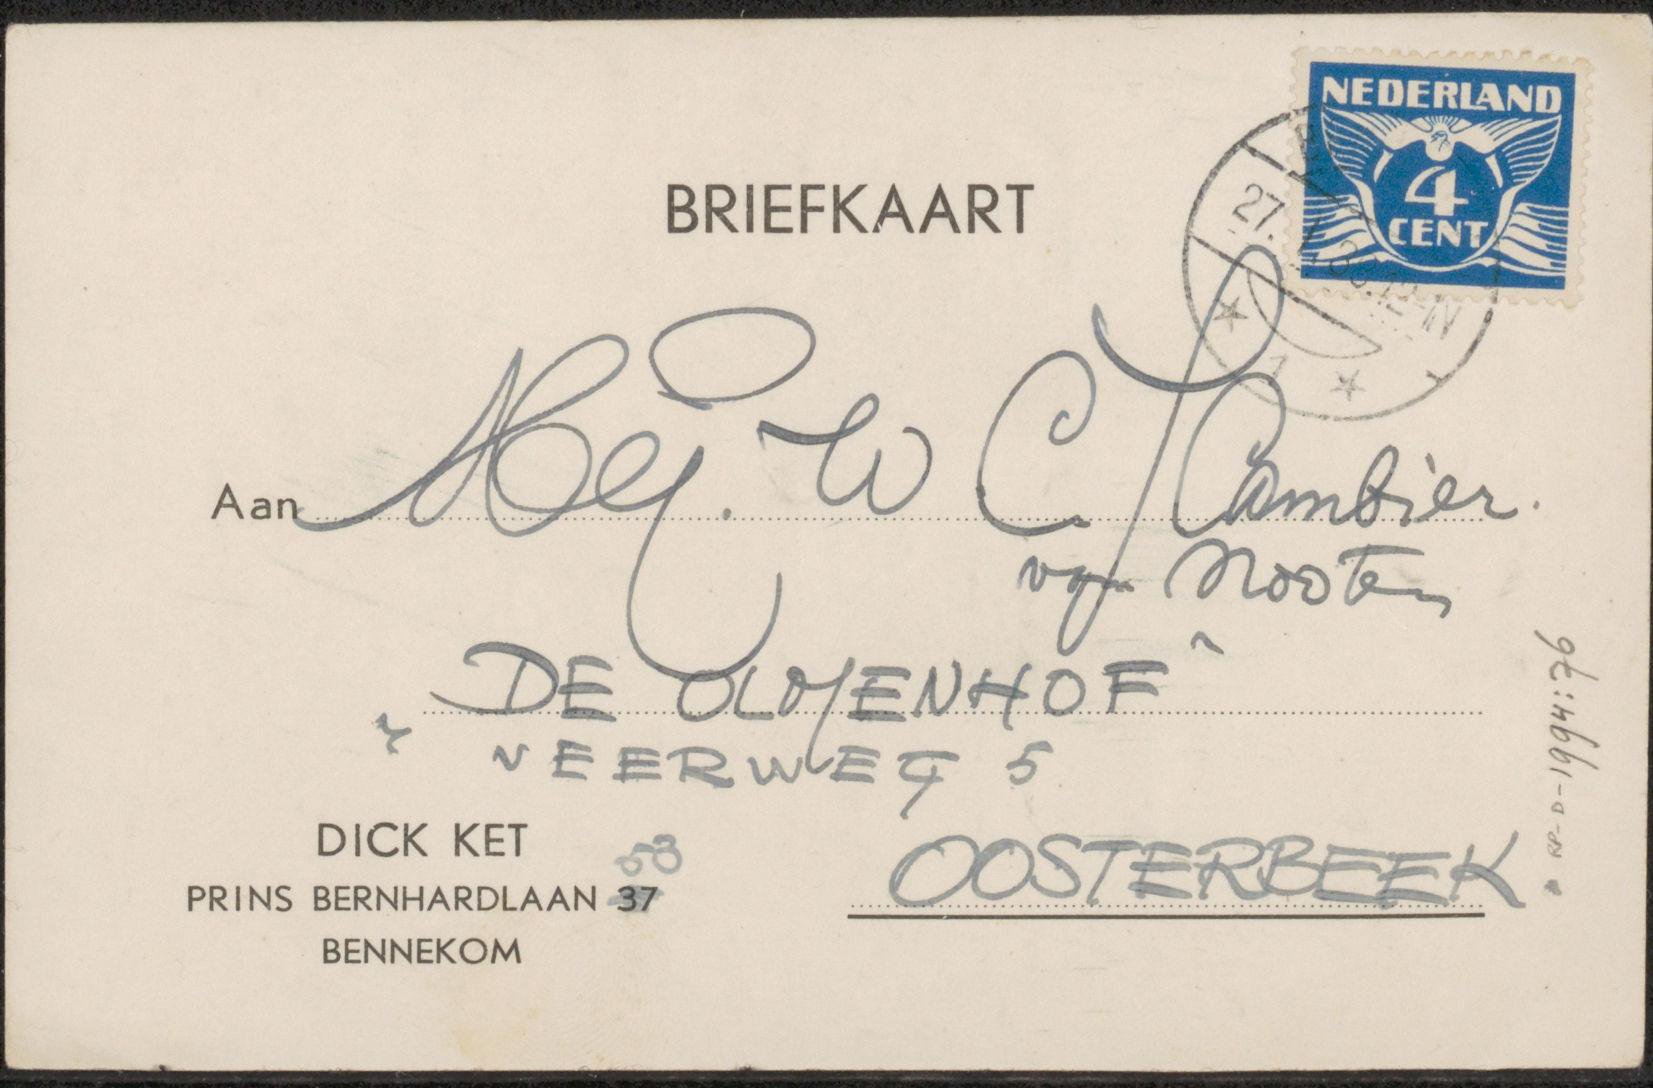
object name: postcard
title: Briefkaart aan Mien Cambier van Nooten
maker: dick ket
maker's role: draughtsman, print maker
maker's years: 1902-1940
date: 1938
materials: cardboard, ink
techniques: pen, writing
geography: bennekom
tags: arnhem, print maker, draughtsman, mien cambier van nooten